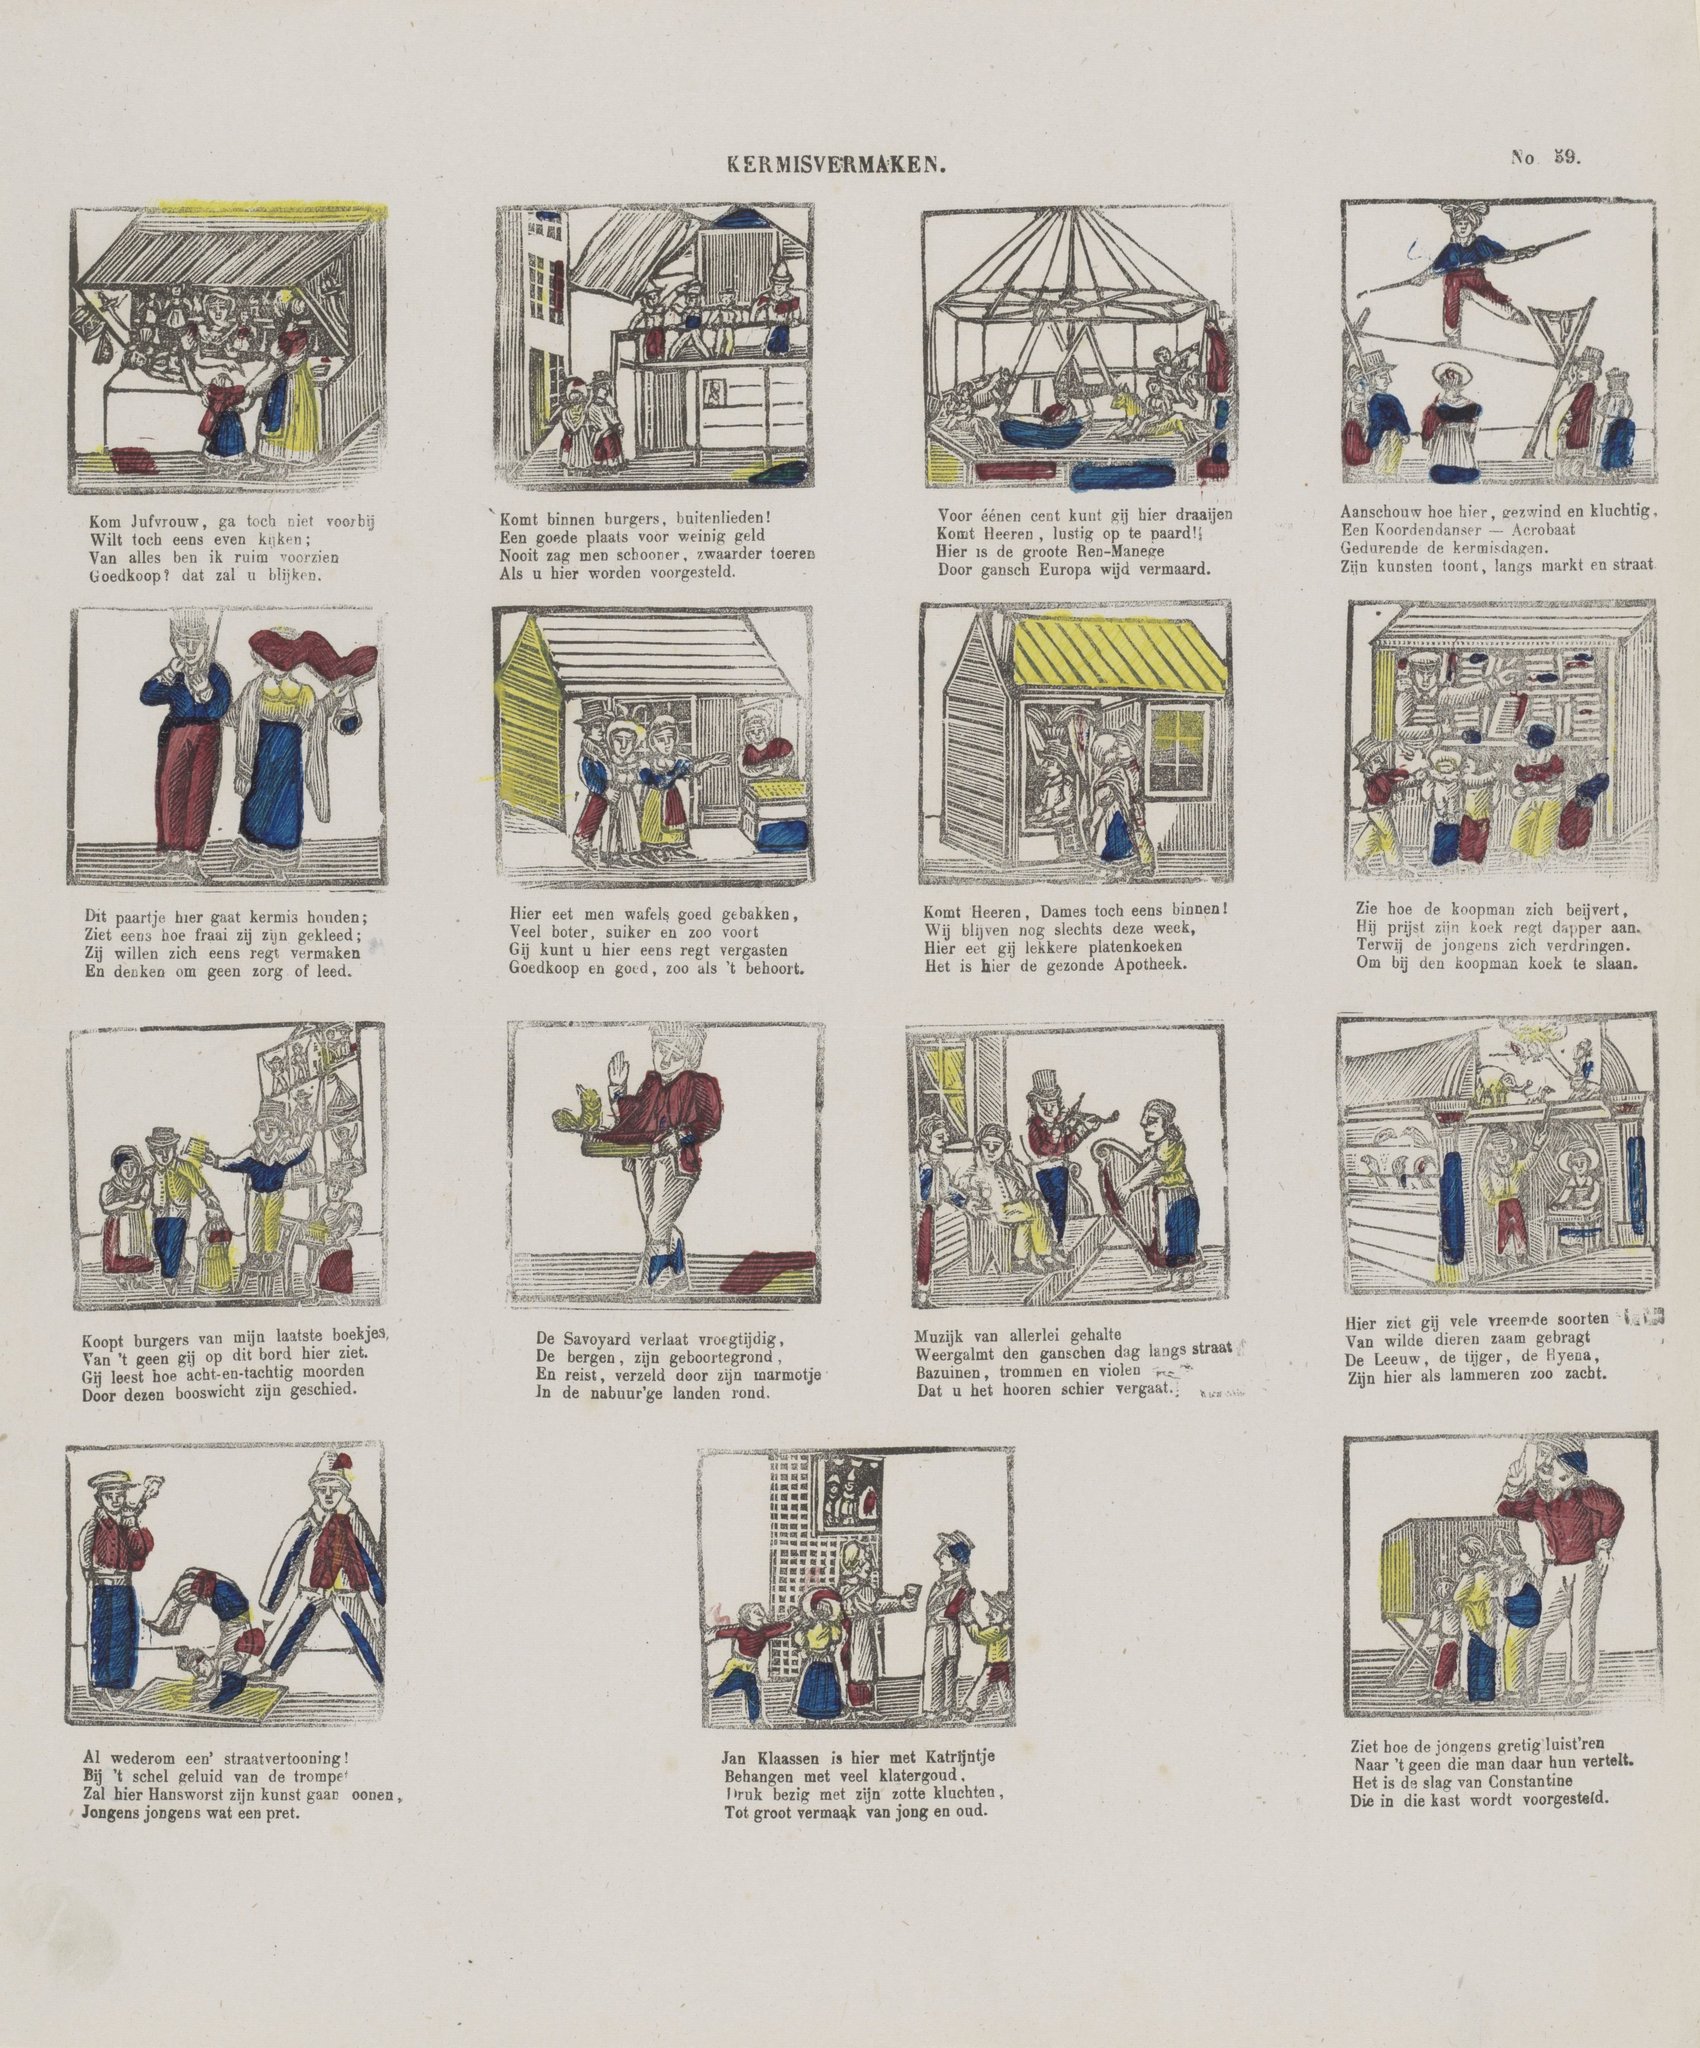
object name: popular print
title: Kermisvermaken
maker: Anonymous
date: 1848-1881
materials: paper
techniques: colour, letterpress printing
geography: netherlands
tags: fancy fair, acrobat ~ circus, pleasure fair and circus, clown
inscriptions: collector's mark: Lugt 2760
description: Blad met 15 kermistaferelen. Onder elke afbeelding een vierregelig vers. Genummerd rechtsboven: No. 59.